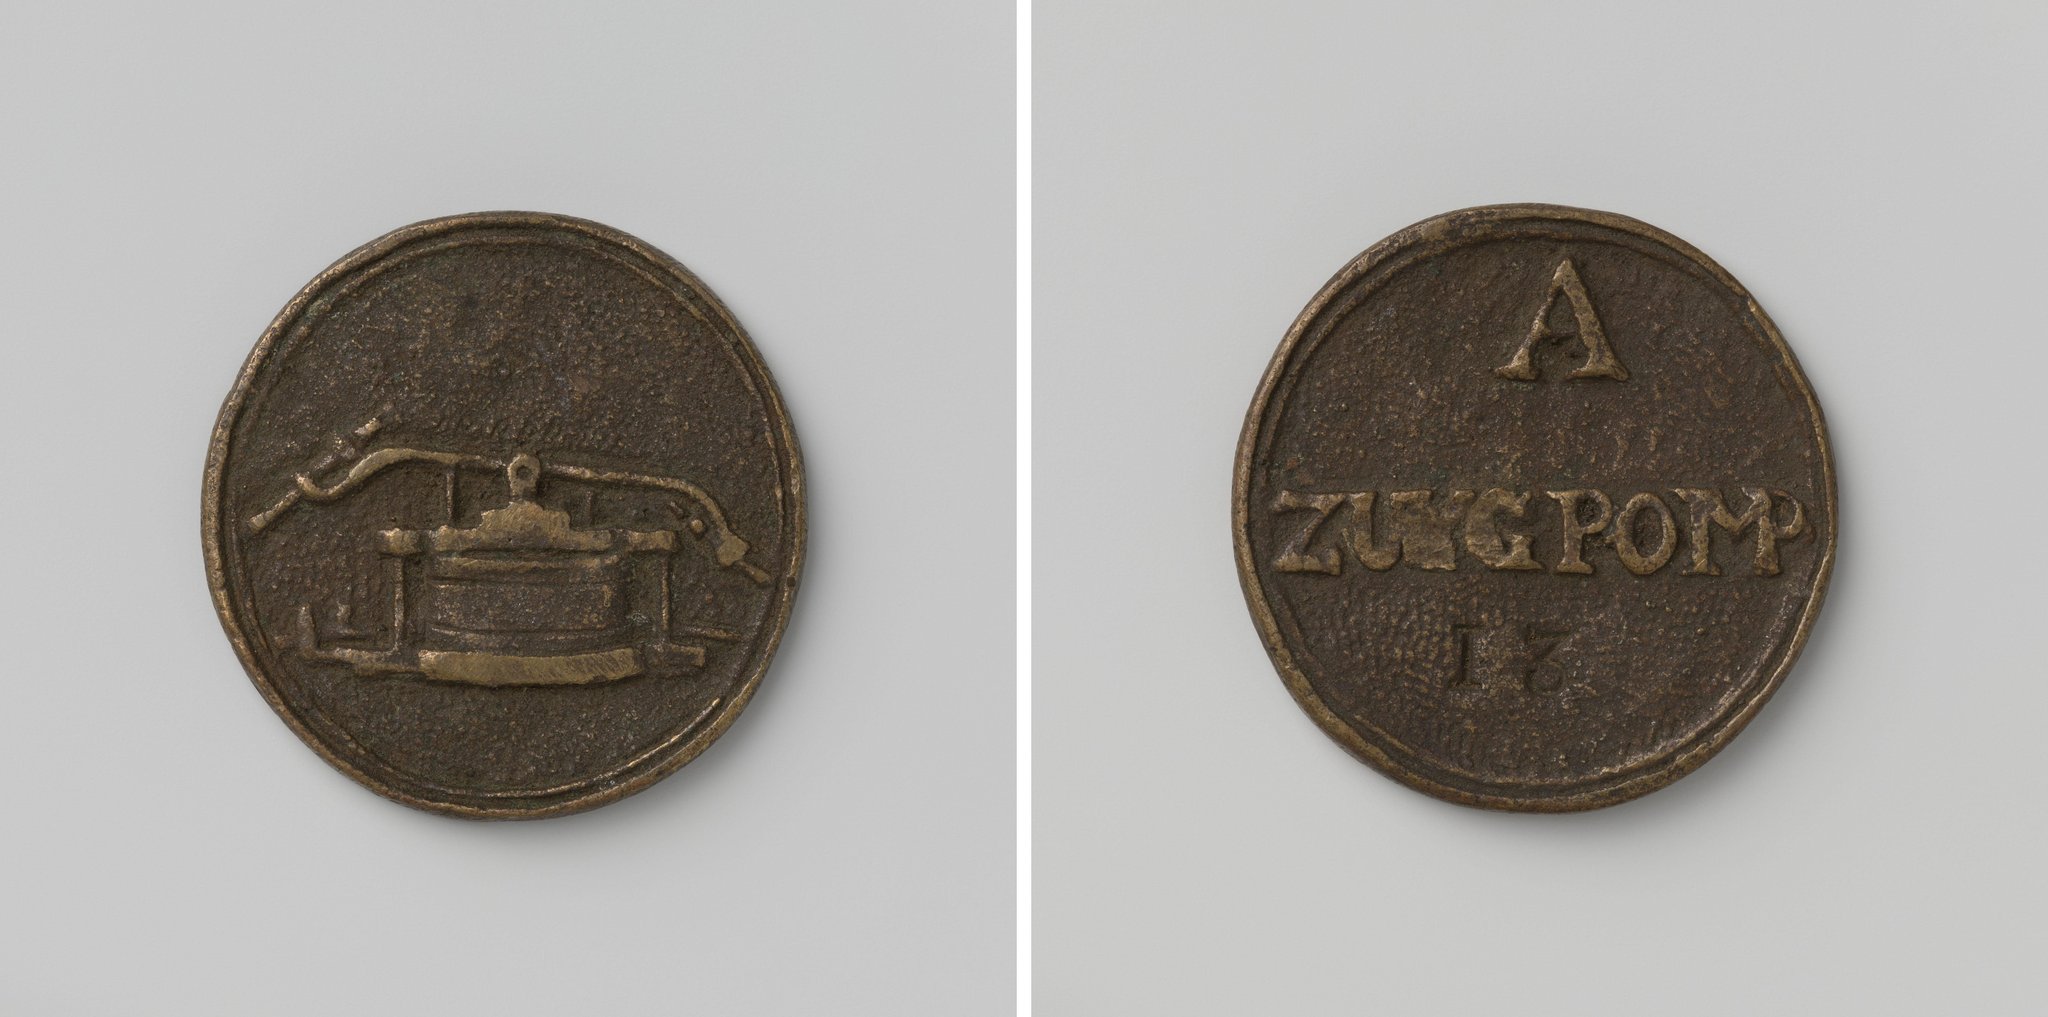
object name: medal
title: Enkhuizen, brandspuitpenning van de man aan de zuigpomp van spuit A met no. 13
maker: Anonymous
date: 1680-1800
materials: brass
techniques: casting, engraving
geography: enkhuizen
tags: enkhuizen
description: Messing penning. Voorzijde: brandspuit. Keerzijde: opschrift boven cijfer 13